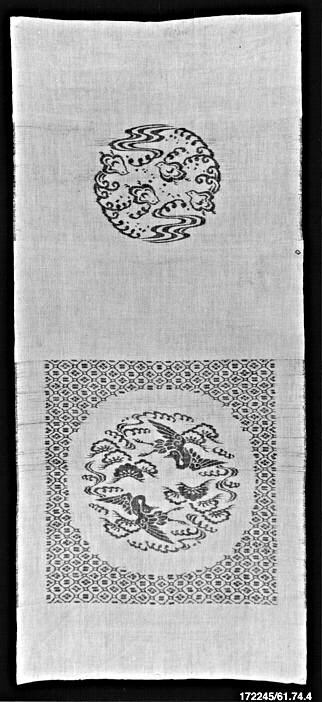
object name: cushion cover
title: Length with Pattern of Roundels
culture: japanese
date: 1901-1950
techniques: weave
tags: birds